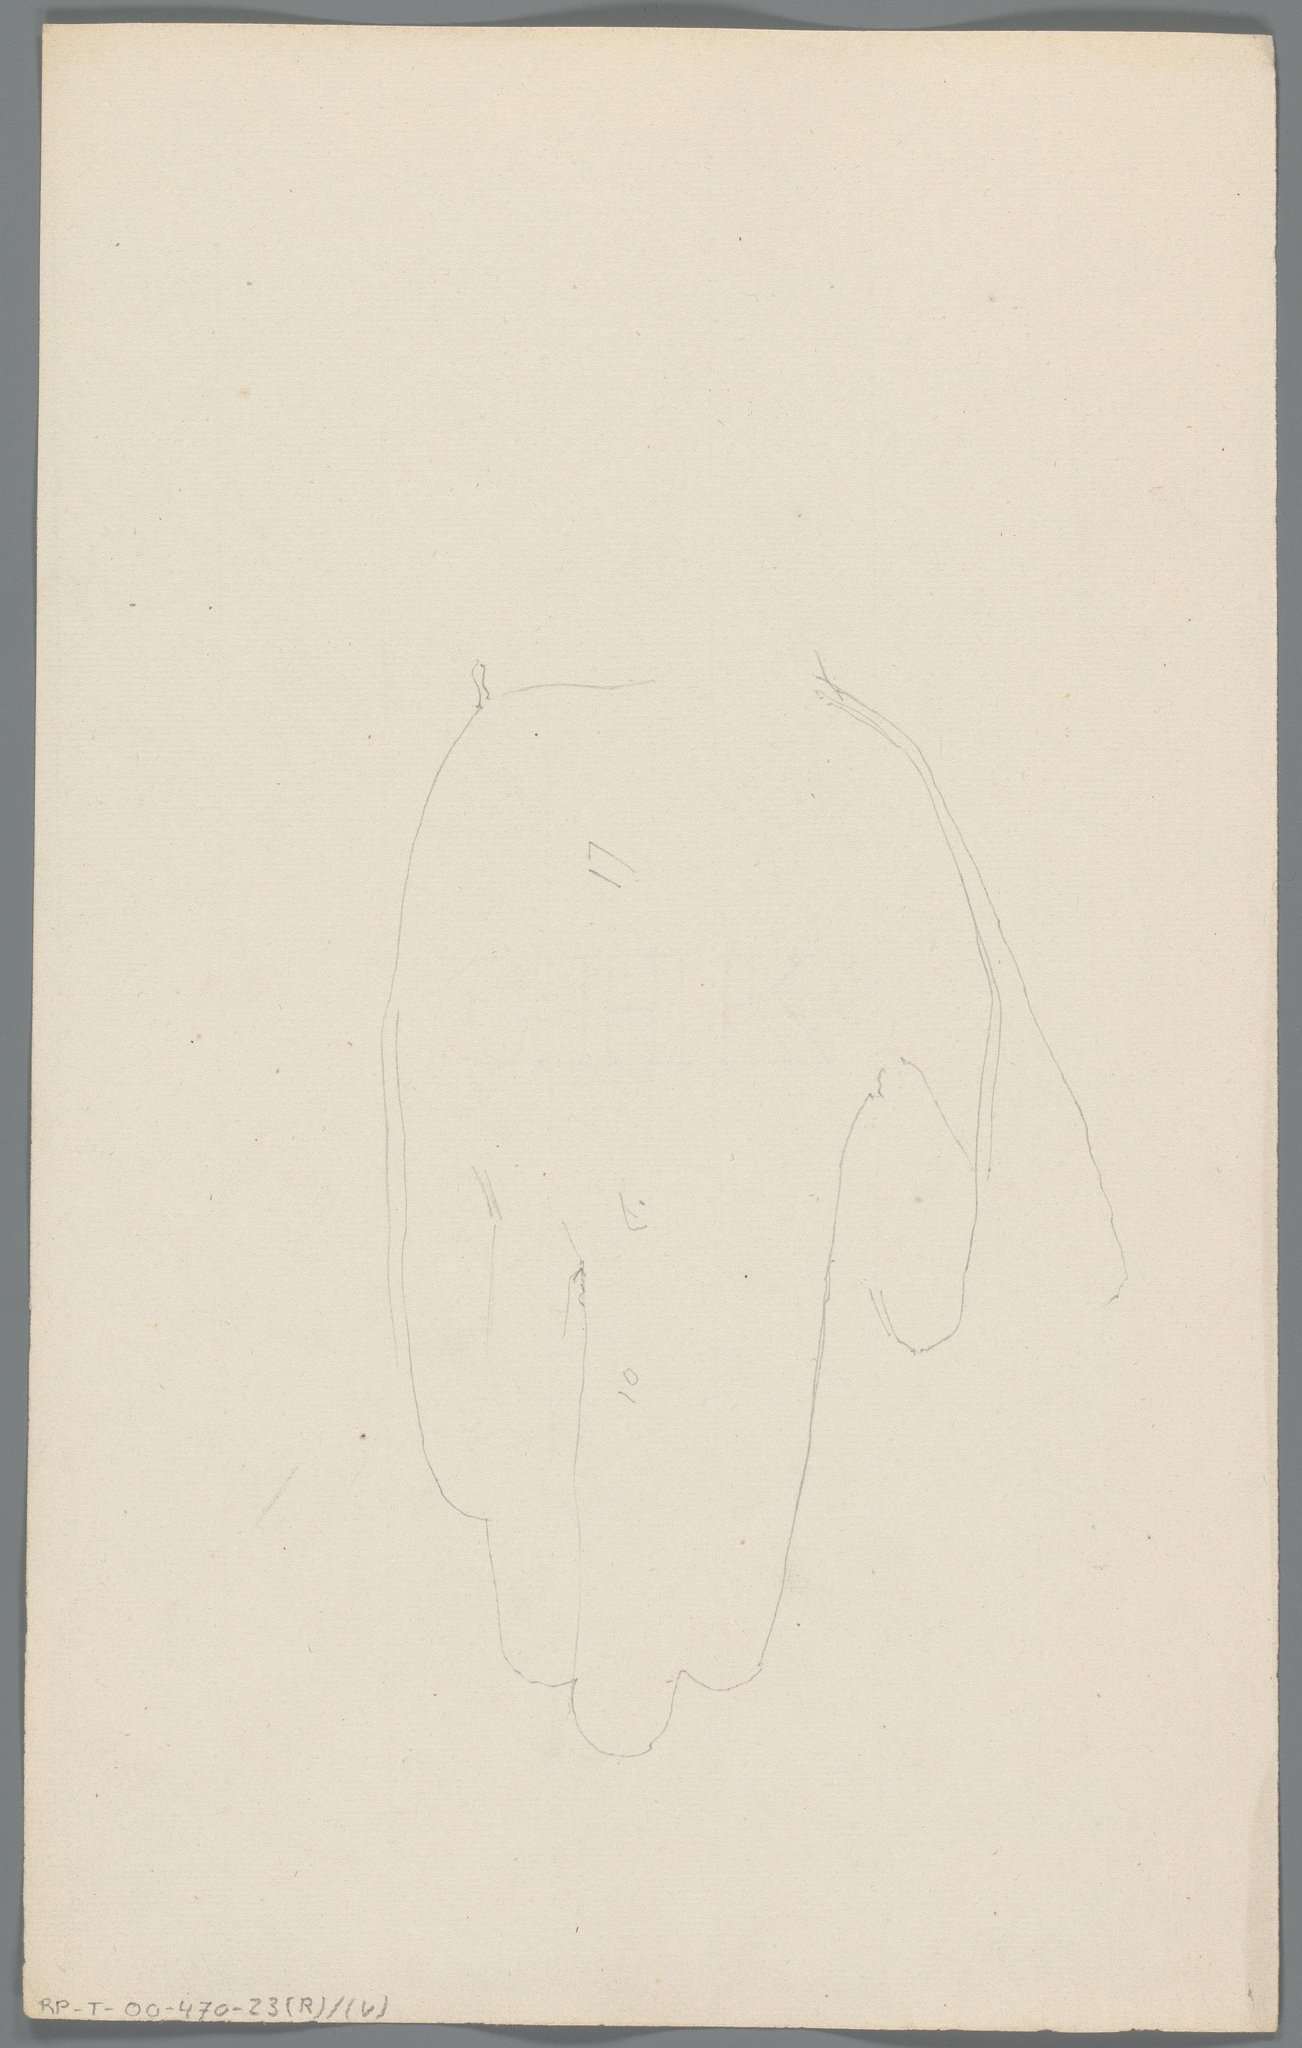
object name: drawing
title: Omtrek van een hand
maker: jacobus everhardus josephus van den berg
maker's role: draughtsman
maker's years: 1802-1861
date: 1812-1861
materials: paper, pencil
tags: postures and gestures of arms and hands in general